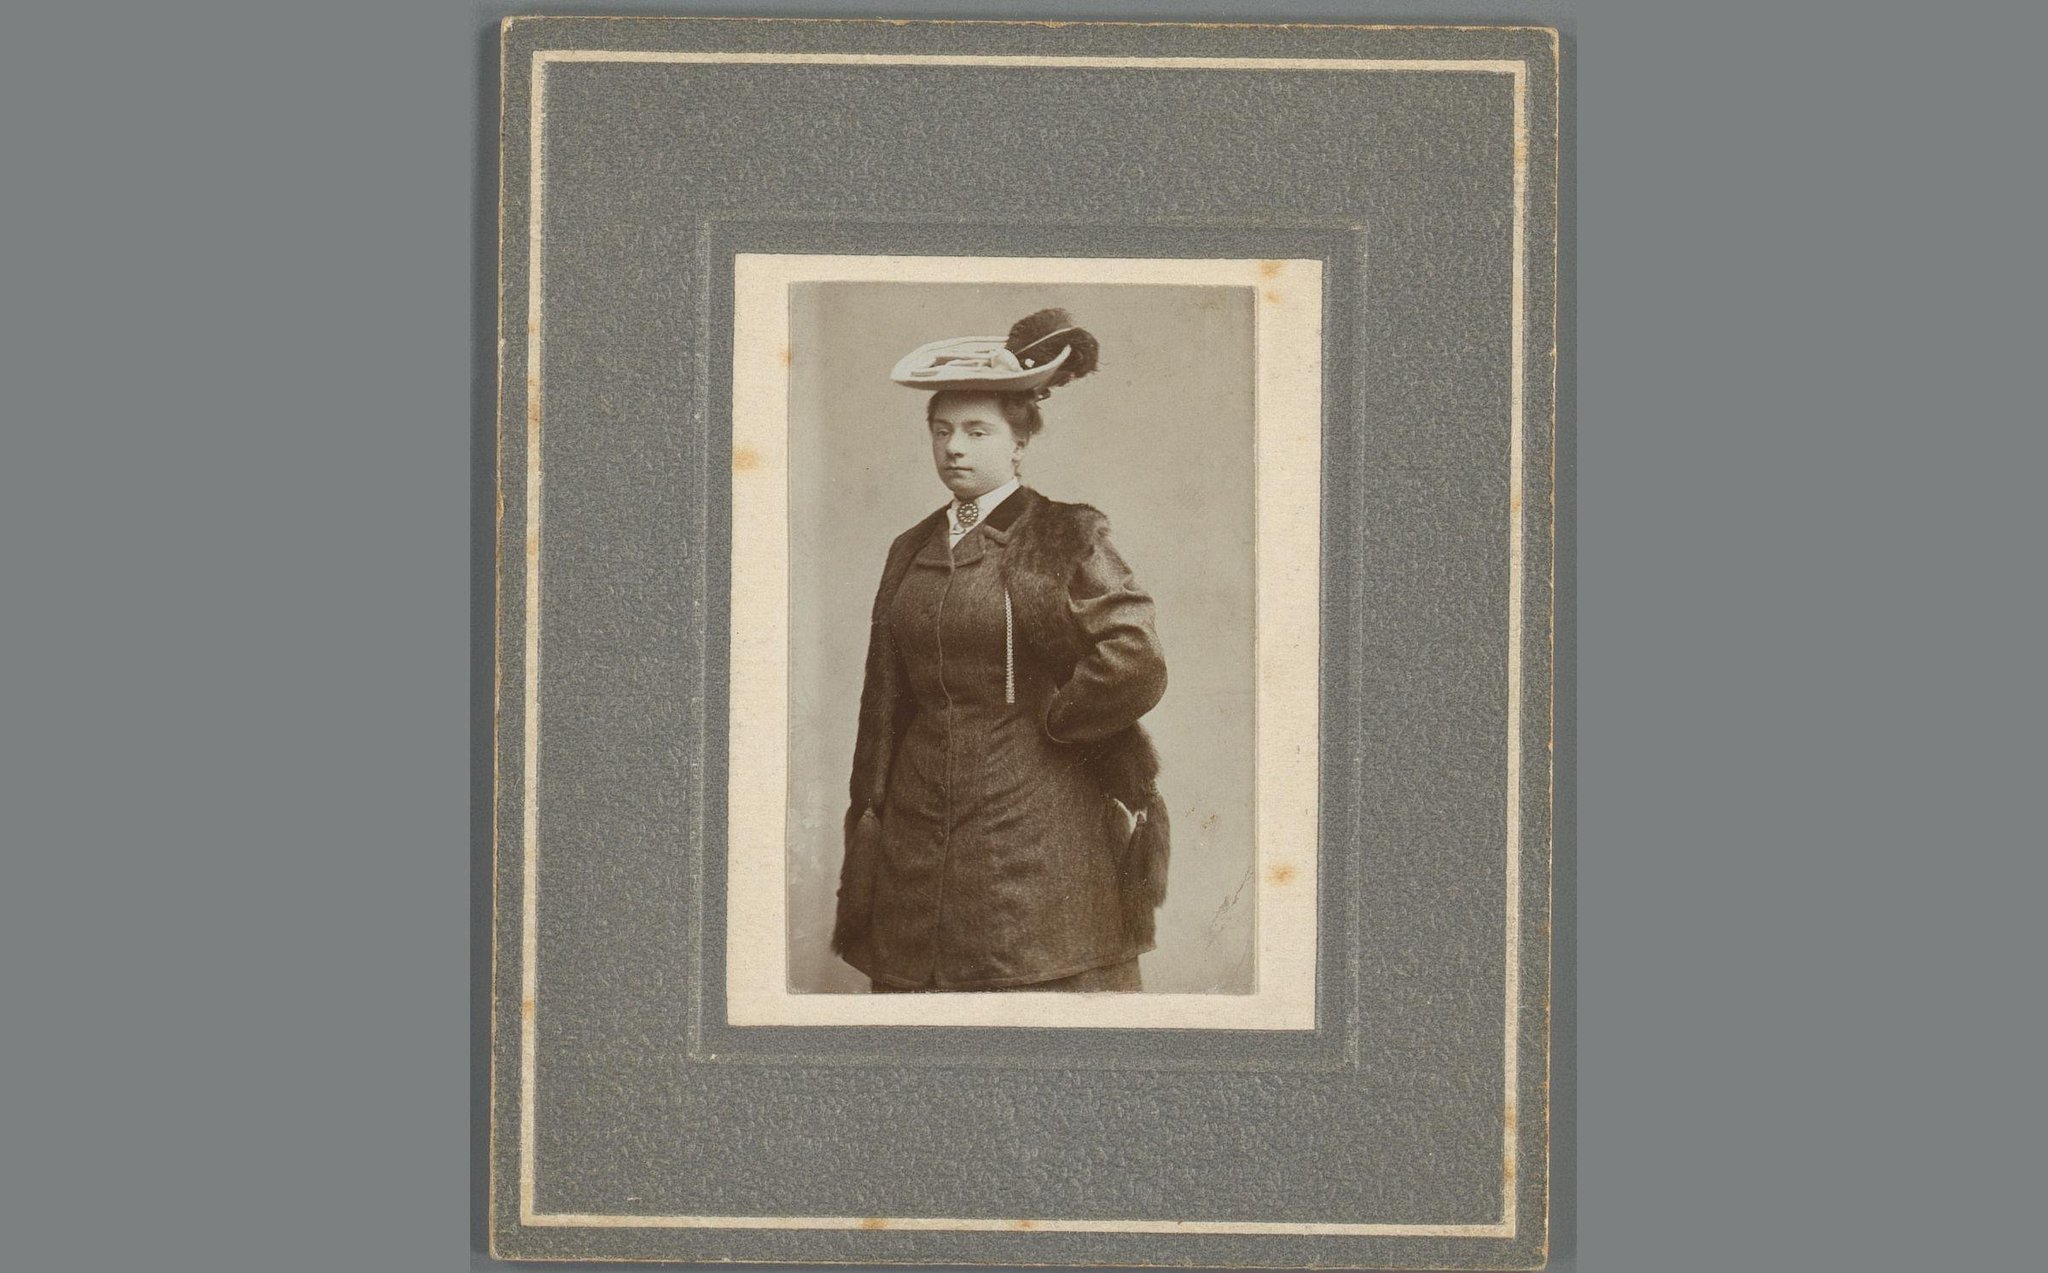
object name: photograph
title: Portret van een onbekende jonge vrouw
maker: Anonymous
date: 1880-1910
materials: paper, cardboard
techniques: collodion silver print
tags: adult woman, anonymous historical person portrayed